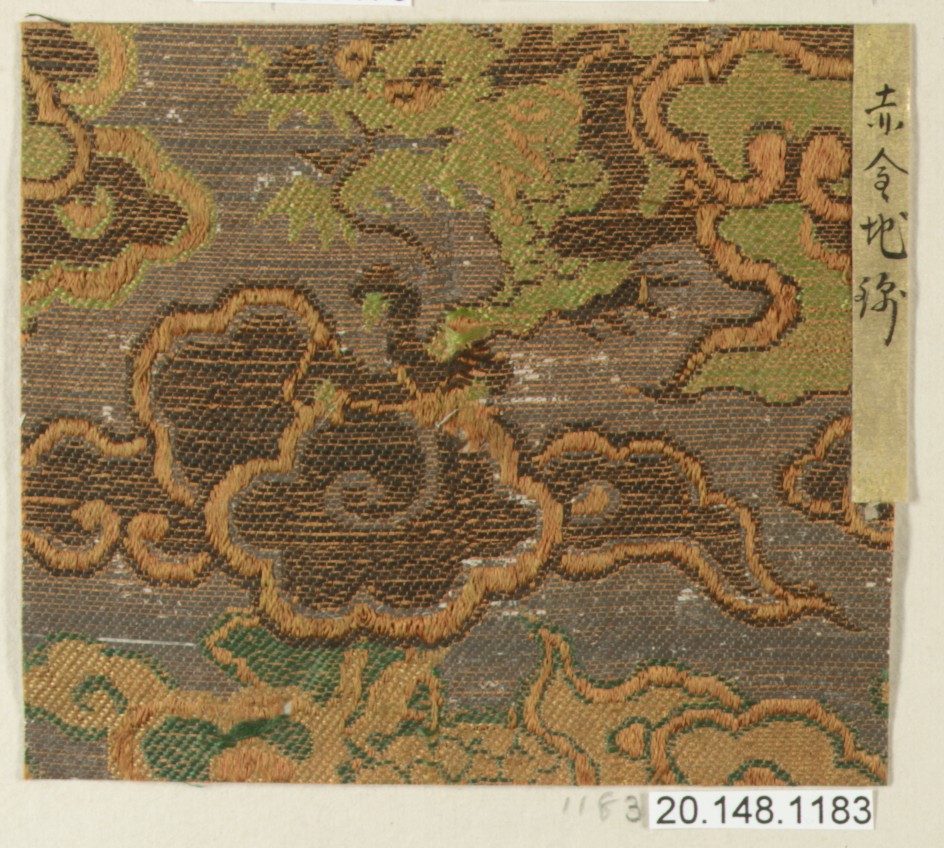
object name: piece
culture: japanese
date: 1601-1700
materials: silk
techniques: compound weave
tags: dragons